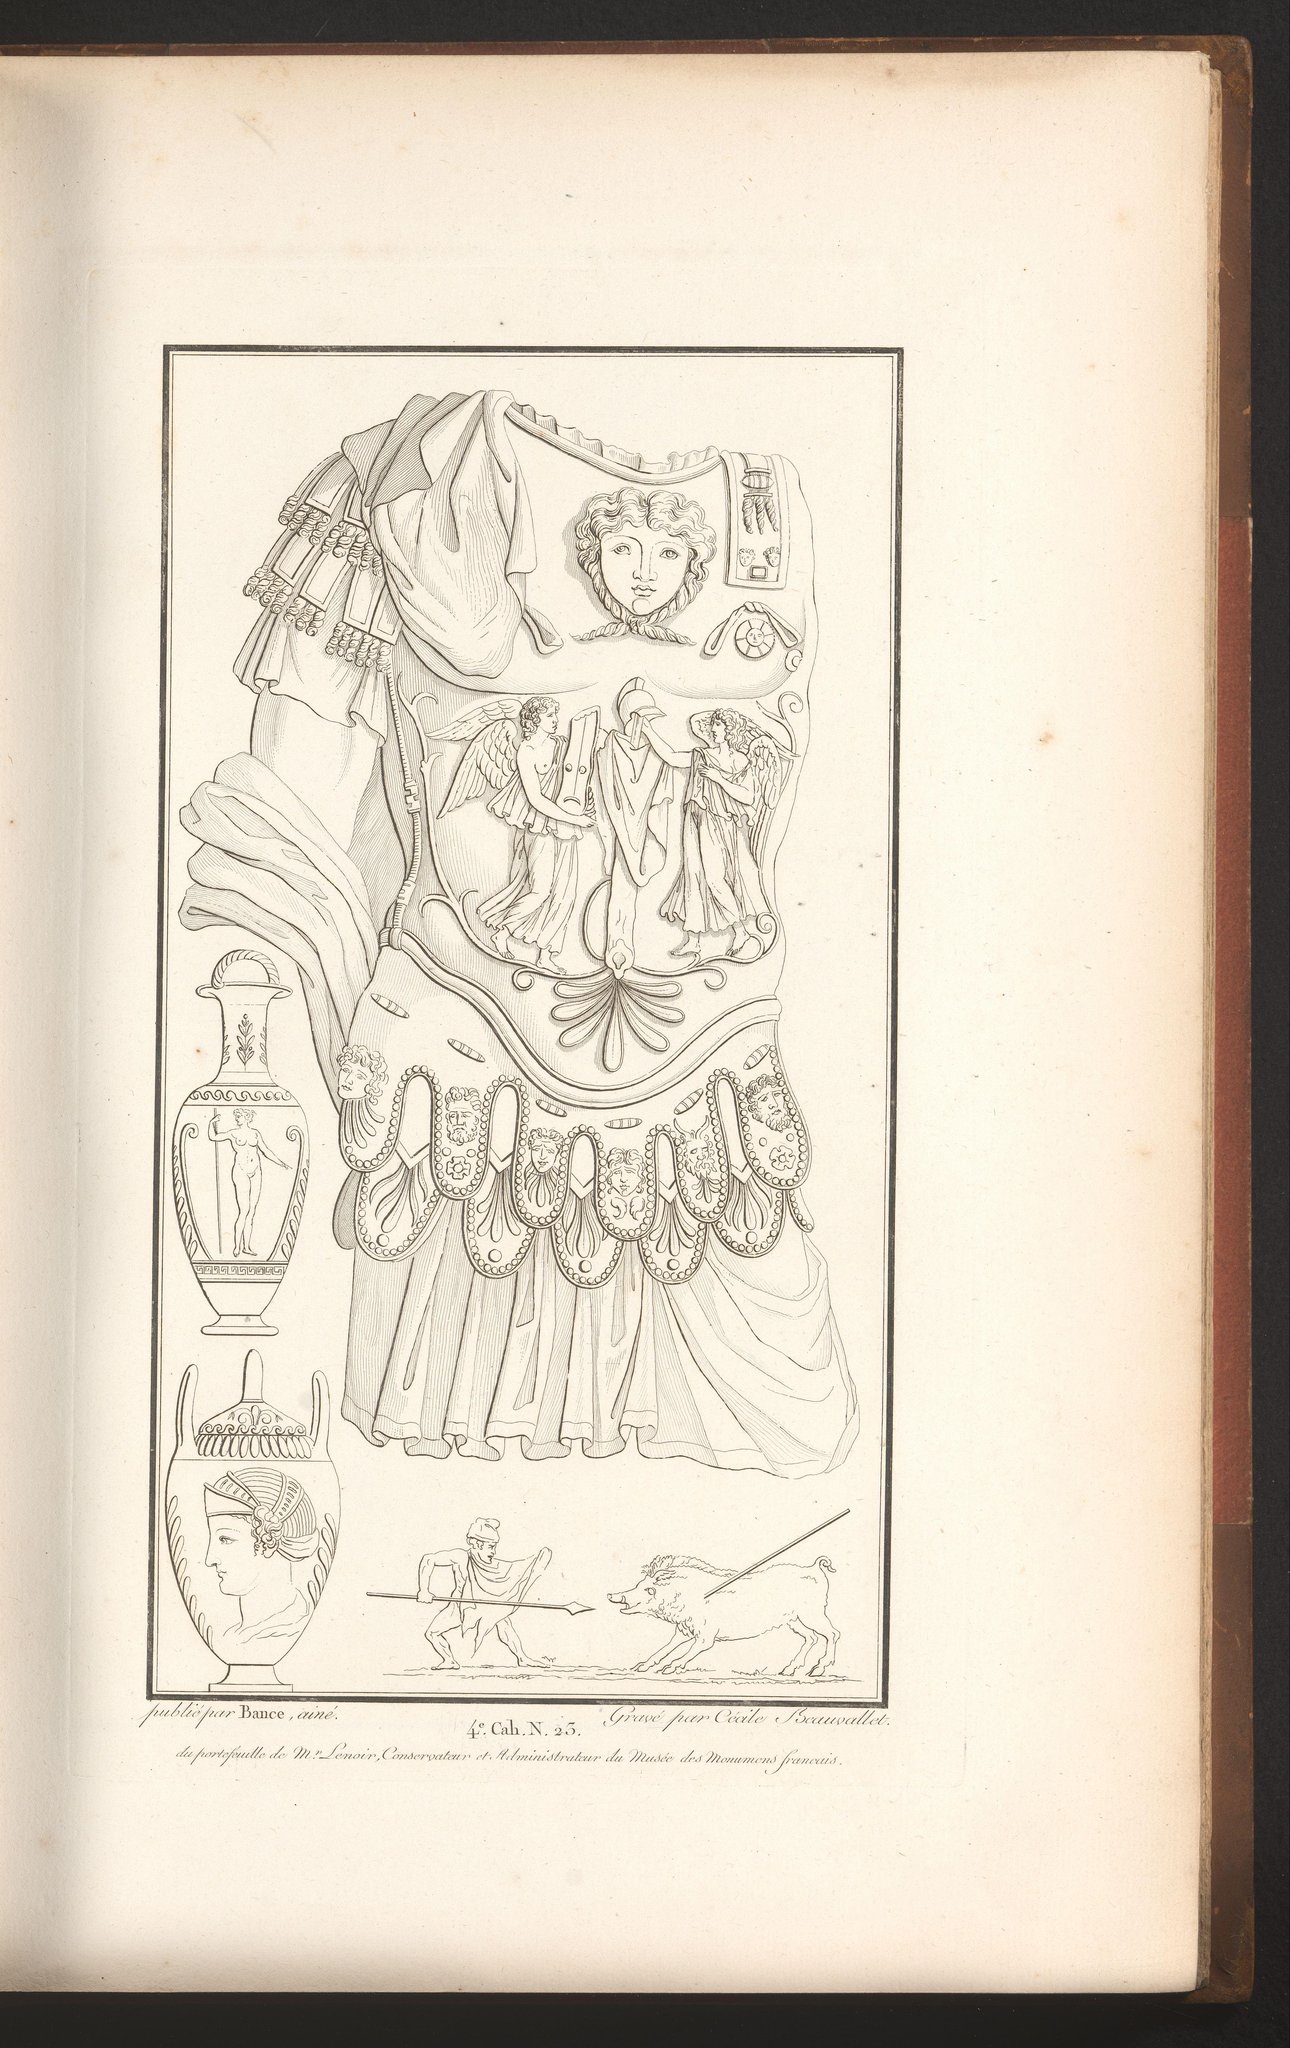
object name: ornament print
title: Kuras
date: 1820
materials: paper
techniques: etching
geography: paris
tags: ornaments ~ art, cuirass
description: Ornamentprent met een Romeins kuras en enkele vazen. Onderdeel (4e. Cah. N. 23) van het prentalbum met twee series van in totaal 138 ornamentprenten door Beauvallet en Normand, 'Fragmens d'Ornemens dans le Style Antique'.